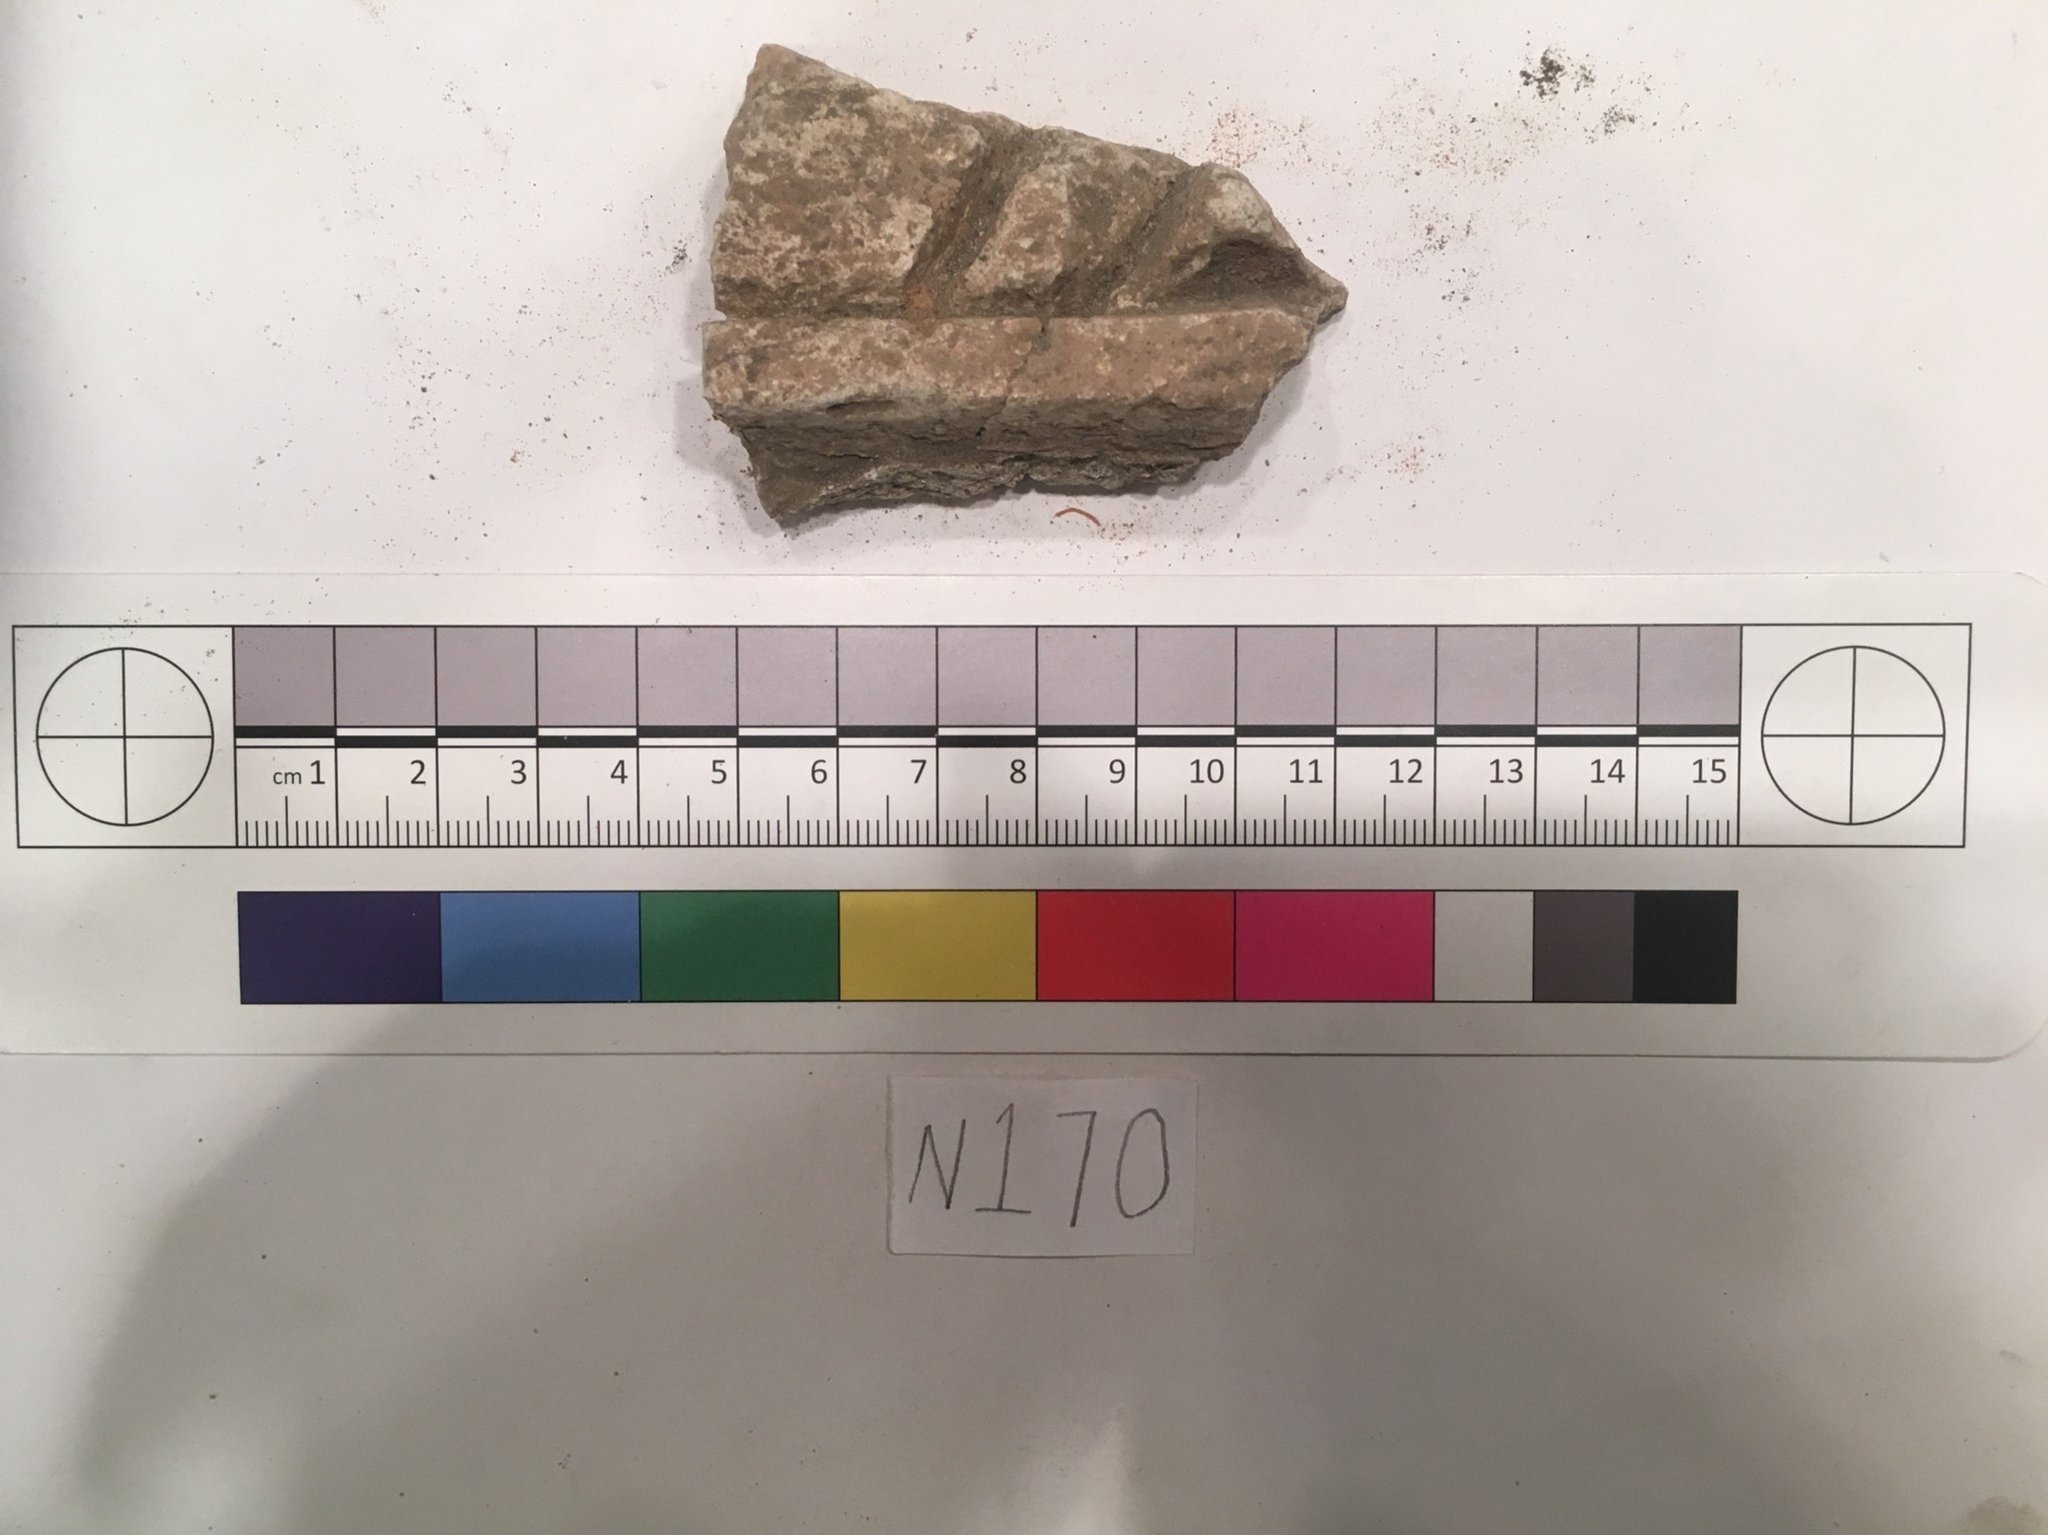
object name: fragment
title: Stucco Fragment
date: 701-1200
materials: plaster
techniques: carving, painting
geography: iran